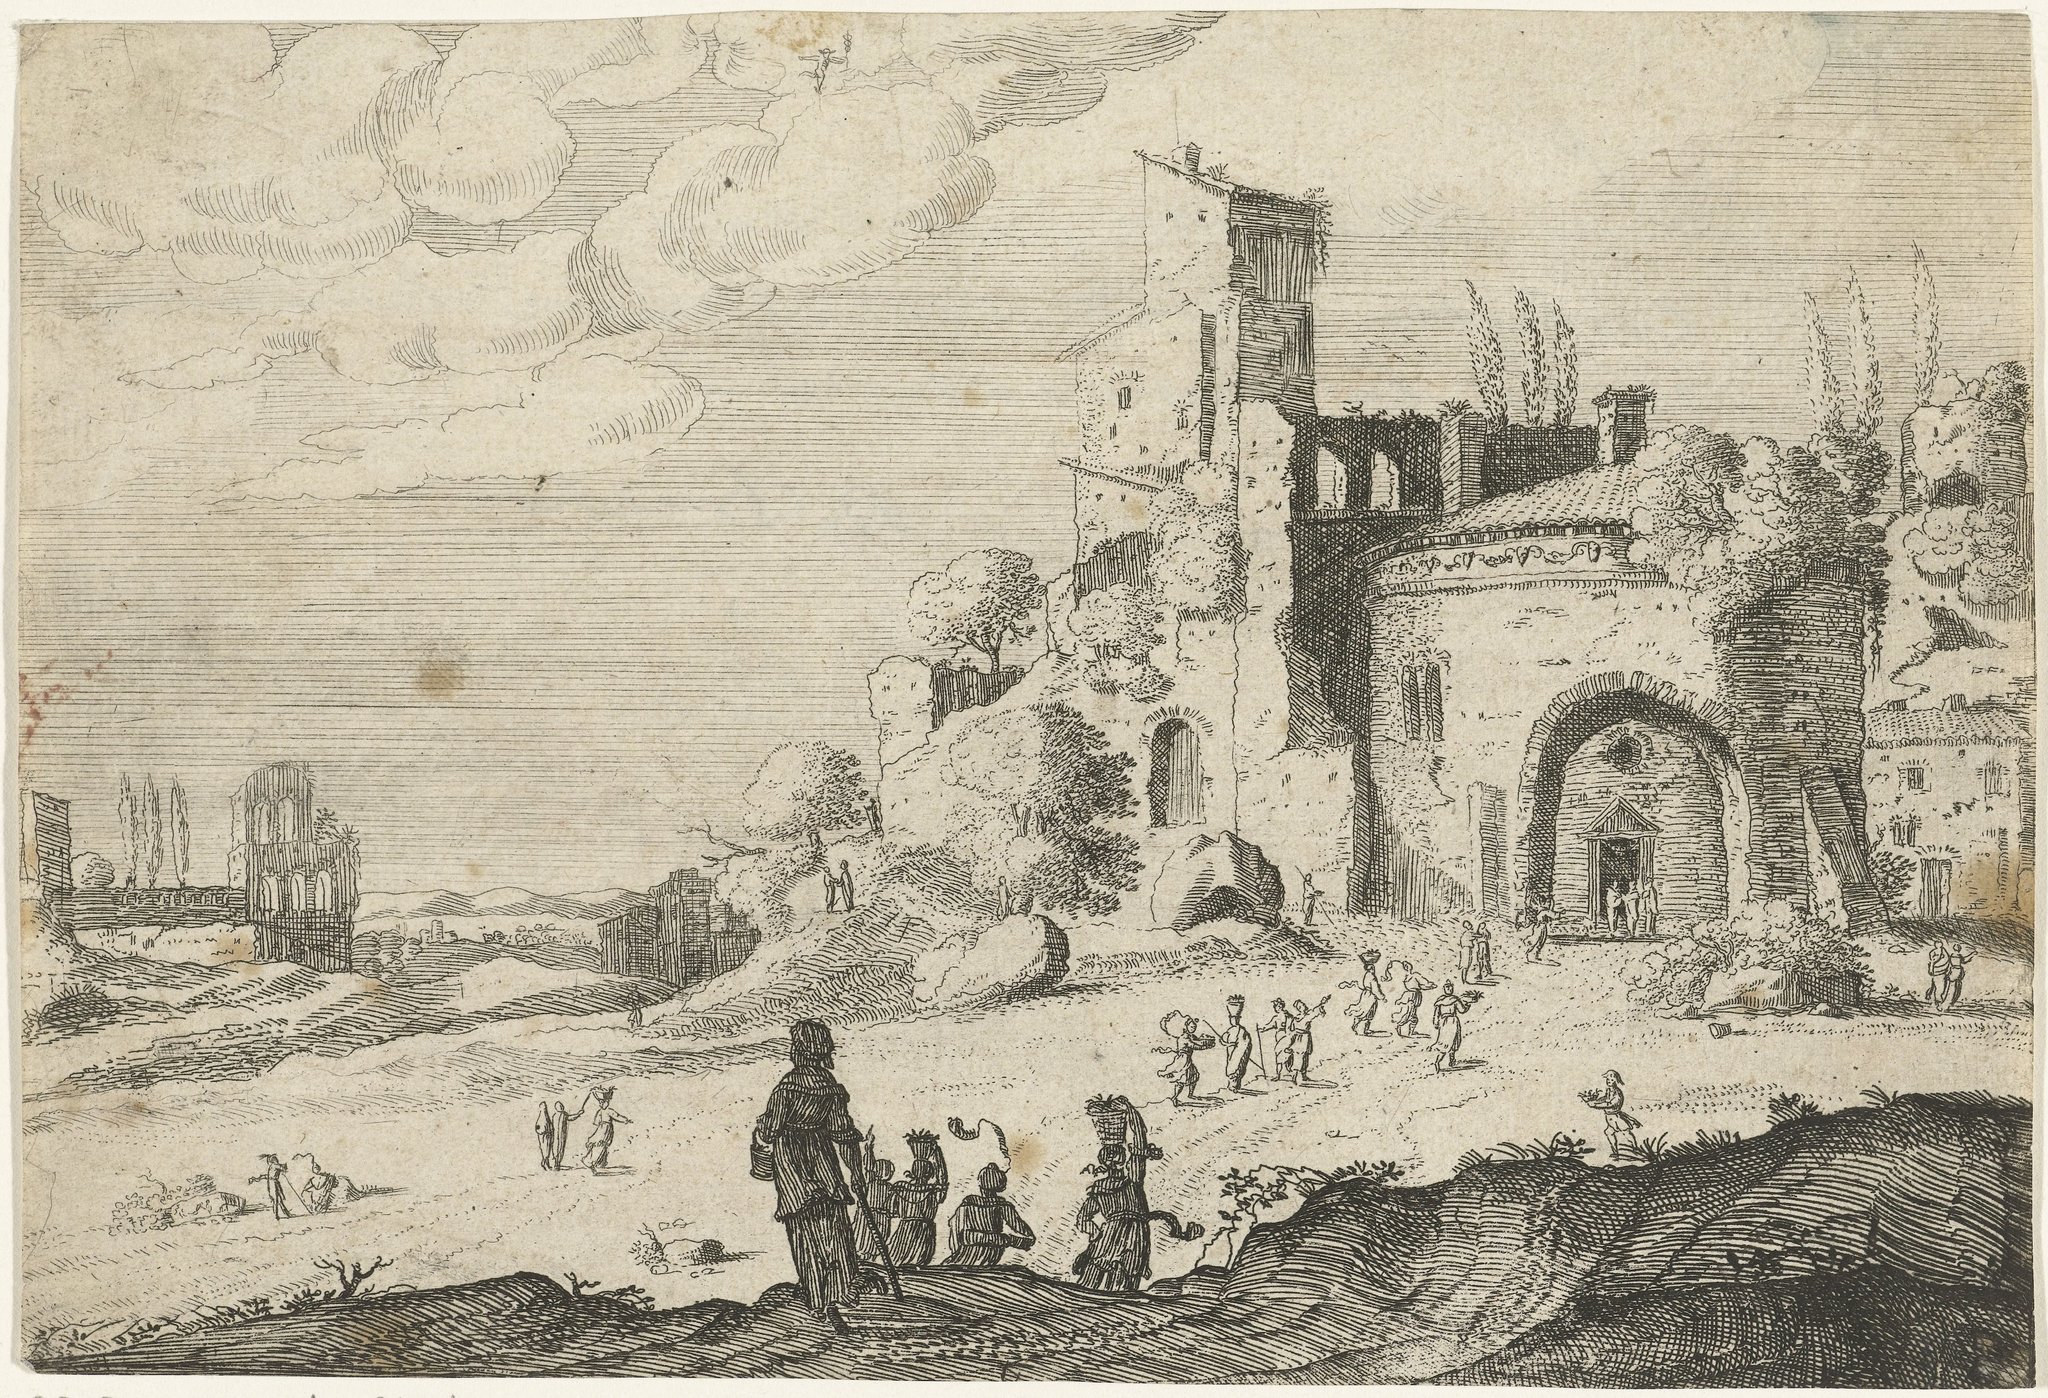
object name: print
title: Landschappen met antieke Romeinse gebouwen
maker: laurens barata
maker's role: print maker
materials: paper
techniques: etching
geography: italy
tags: landscape with ruins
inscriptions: collector's mark: Lugt 2228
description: Landschap met een Romeins gebouw. Een groep vrouwen met manden loopt op de toegangspoort af.